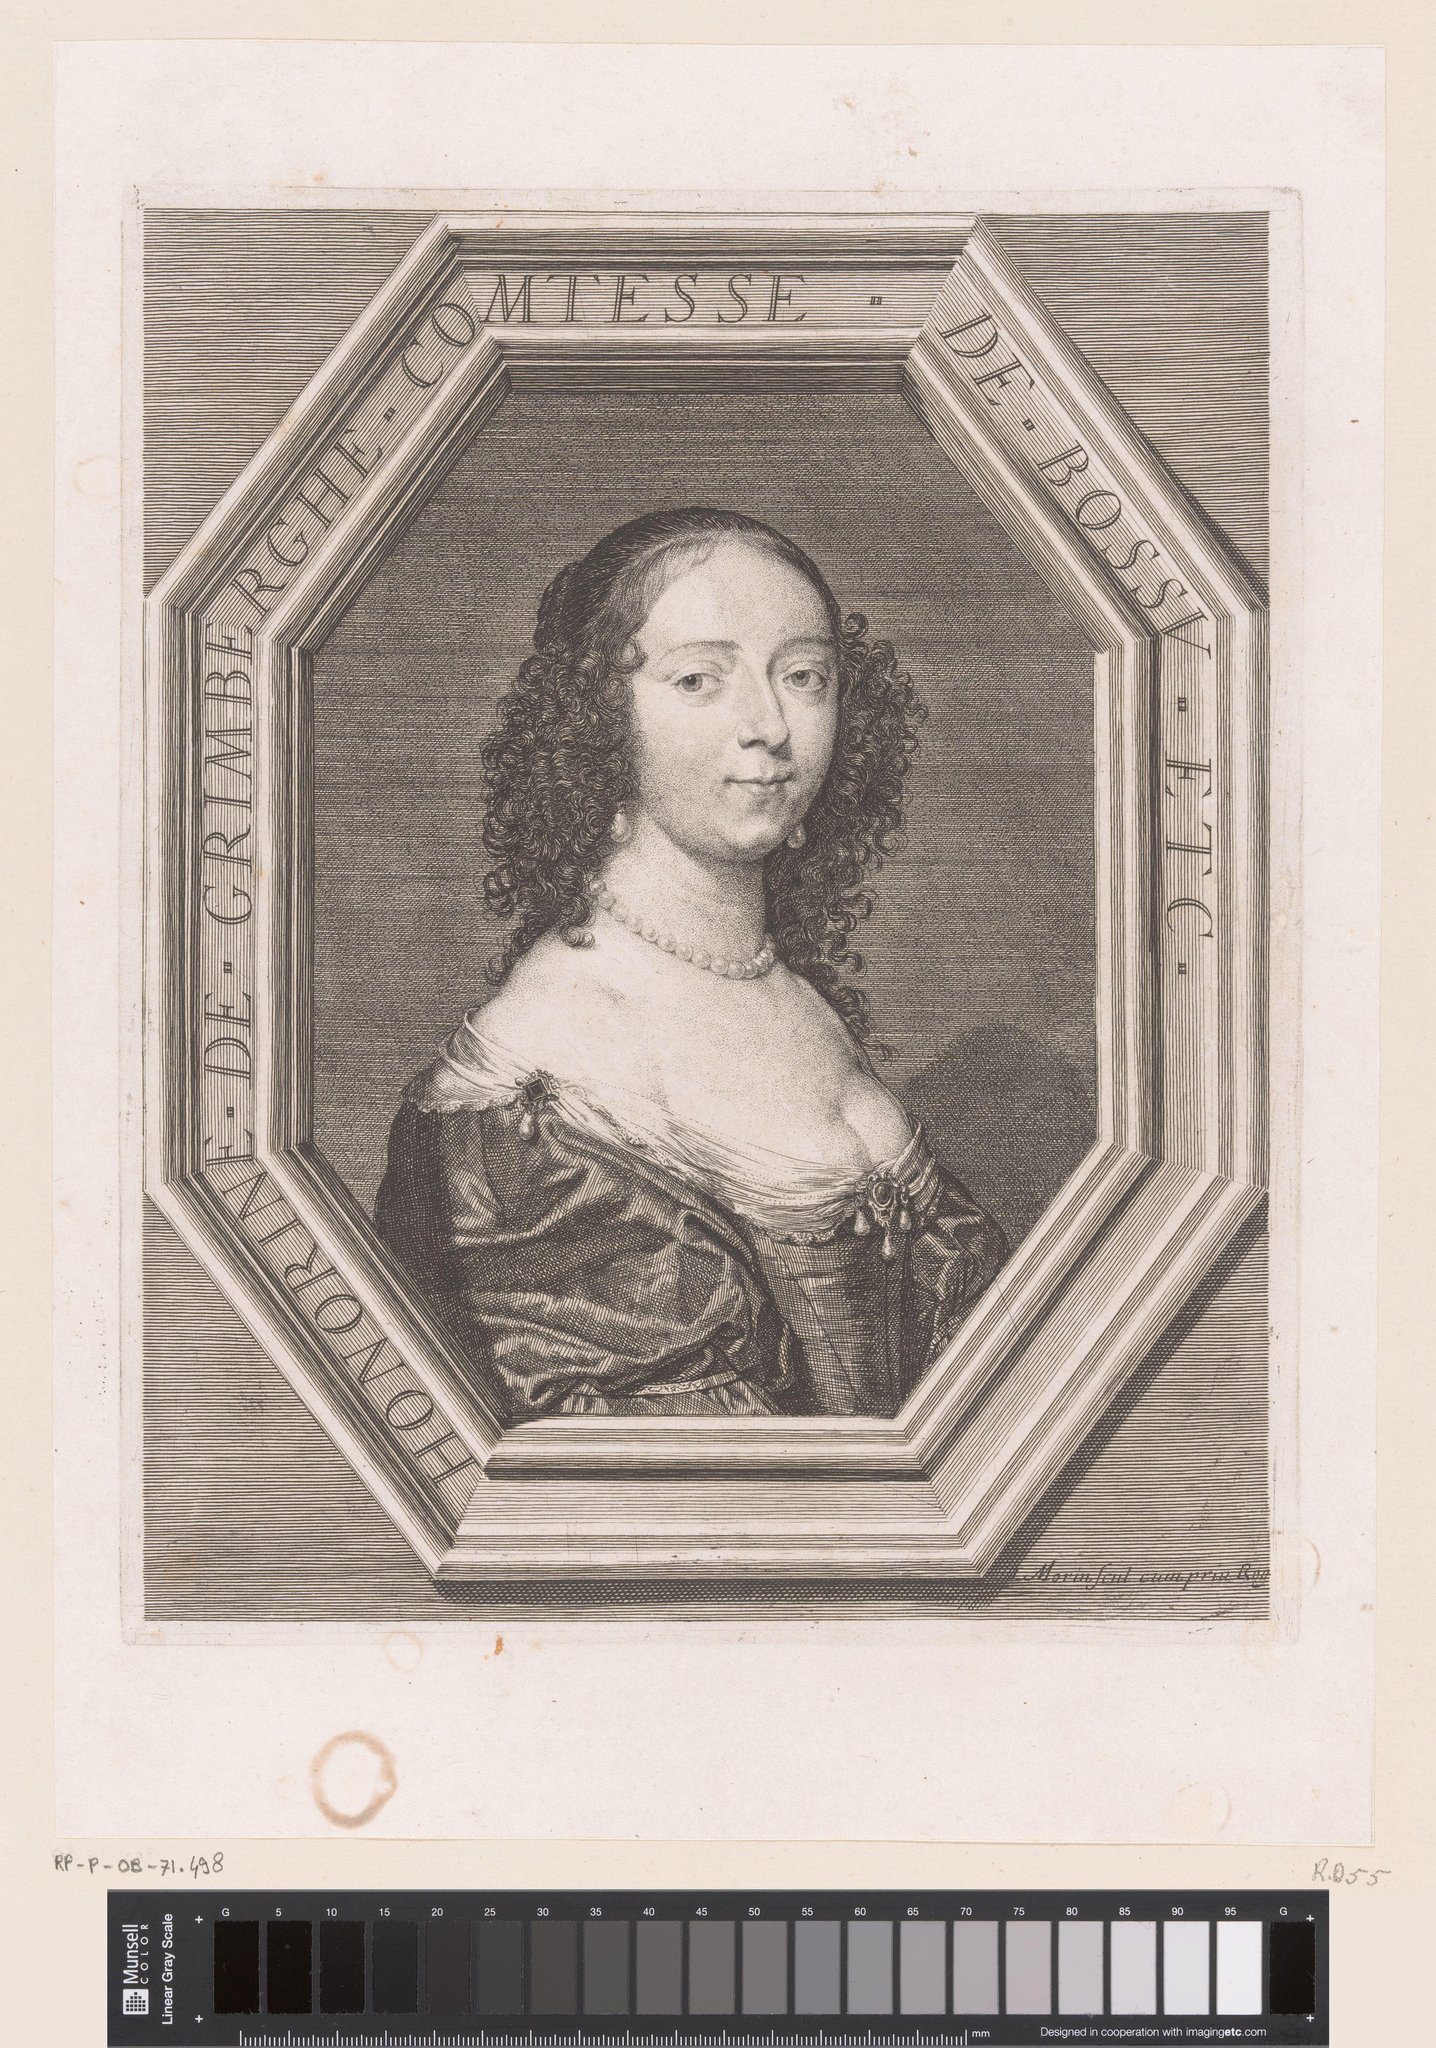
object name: print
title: Portret van Honorée de Glimes-Grimberghe, Gravin van Bossut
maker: jean morin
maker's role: print maker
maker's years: 1605-1650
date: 1640-1650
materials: paper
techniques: etching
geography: paris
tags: historical persons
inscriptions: collector's mark: Lugt 2228